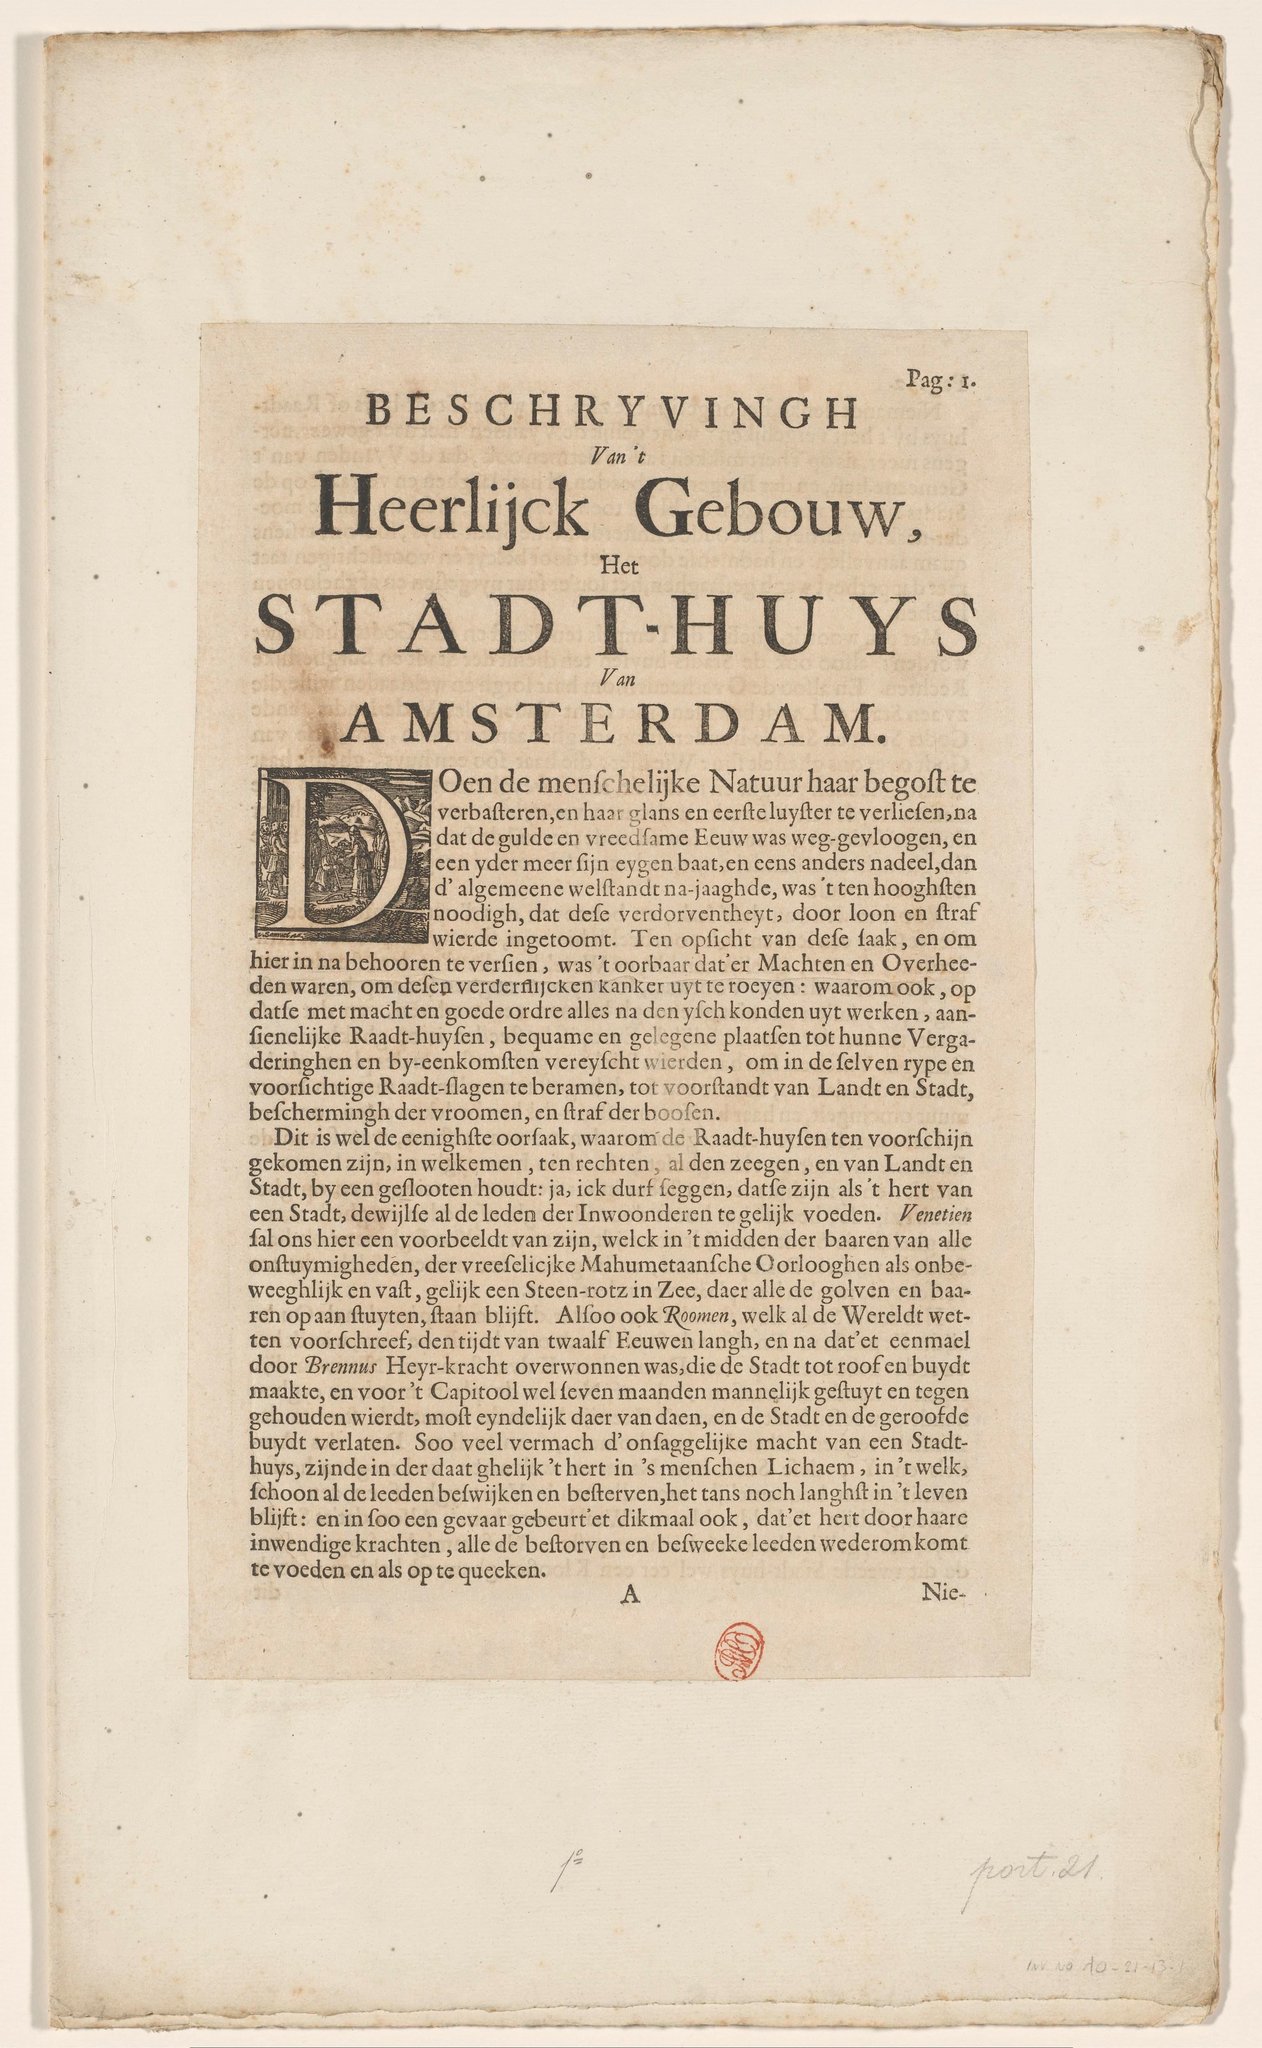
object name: text sheet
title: Beschrijving van het Stadhuis op de Dam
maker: dancker danckerts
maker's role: print maker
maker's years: 1633-1666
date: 1661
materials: paper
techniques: letterpress printing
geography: amsterdam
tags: townhall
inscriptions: collector's mark: Lugt 195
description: Tekst gebruikt in: Afbeelding van 't stadt huys van Amsterdam, In dartigh Coopere Plaaten, geordineert door Jacob van Campen; en Geteeckent door Iacob Vennekool. Amsterdam: Dancker Danckerts, 1661. Zie RP-P-AO-21-13-30 voor de bijhorende titelpagina. Zie RP-P-AO-21-13-2, RP-P-AO-21-13-3, RP-P-AO-21-13-4, RP-P-AO-21-13-5, RP-P-AO-21-13-6, RP-P-AO-21-13-7, RP-P-AO-21-13-8, RP-P-AO-21-13-9, RP-P-AO-21-13-10, RP-P-AO-21-13-11, RP-P-AO-21-13-12, RP-P-AO-21-13-13, RP-P-AO-21-13-14, RP-P-AO-21-13-15, RP-P-AO-21-13-16, RP-P-AO-21-13-17, RP-P-AO-21-13-18, RP-P-AO-21-13-19, RP-P-AO-21-13-20, RP-P-AO-21-13-21, RP-P-AO-21-13-22, RP-P-AO-21-13-23, RP-P-AO-21-13-24, RP-P-AO-21-13-25, RP-P-AO-21-13-26, RP-P-AO-21-13-27, RP-P-AO-21-13-28 en RP-P-AO-21-13-29 voor prenten uit deze publicatie.